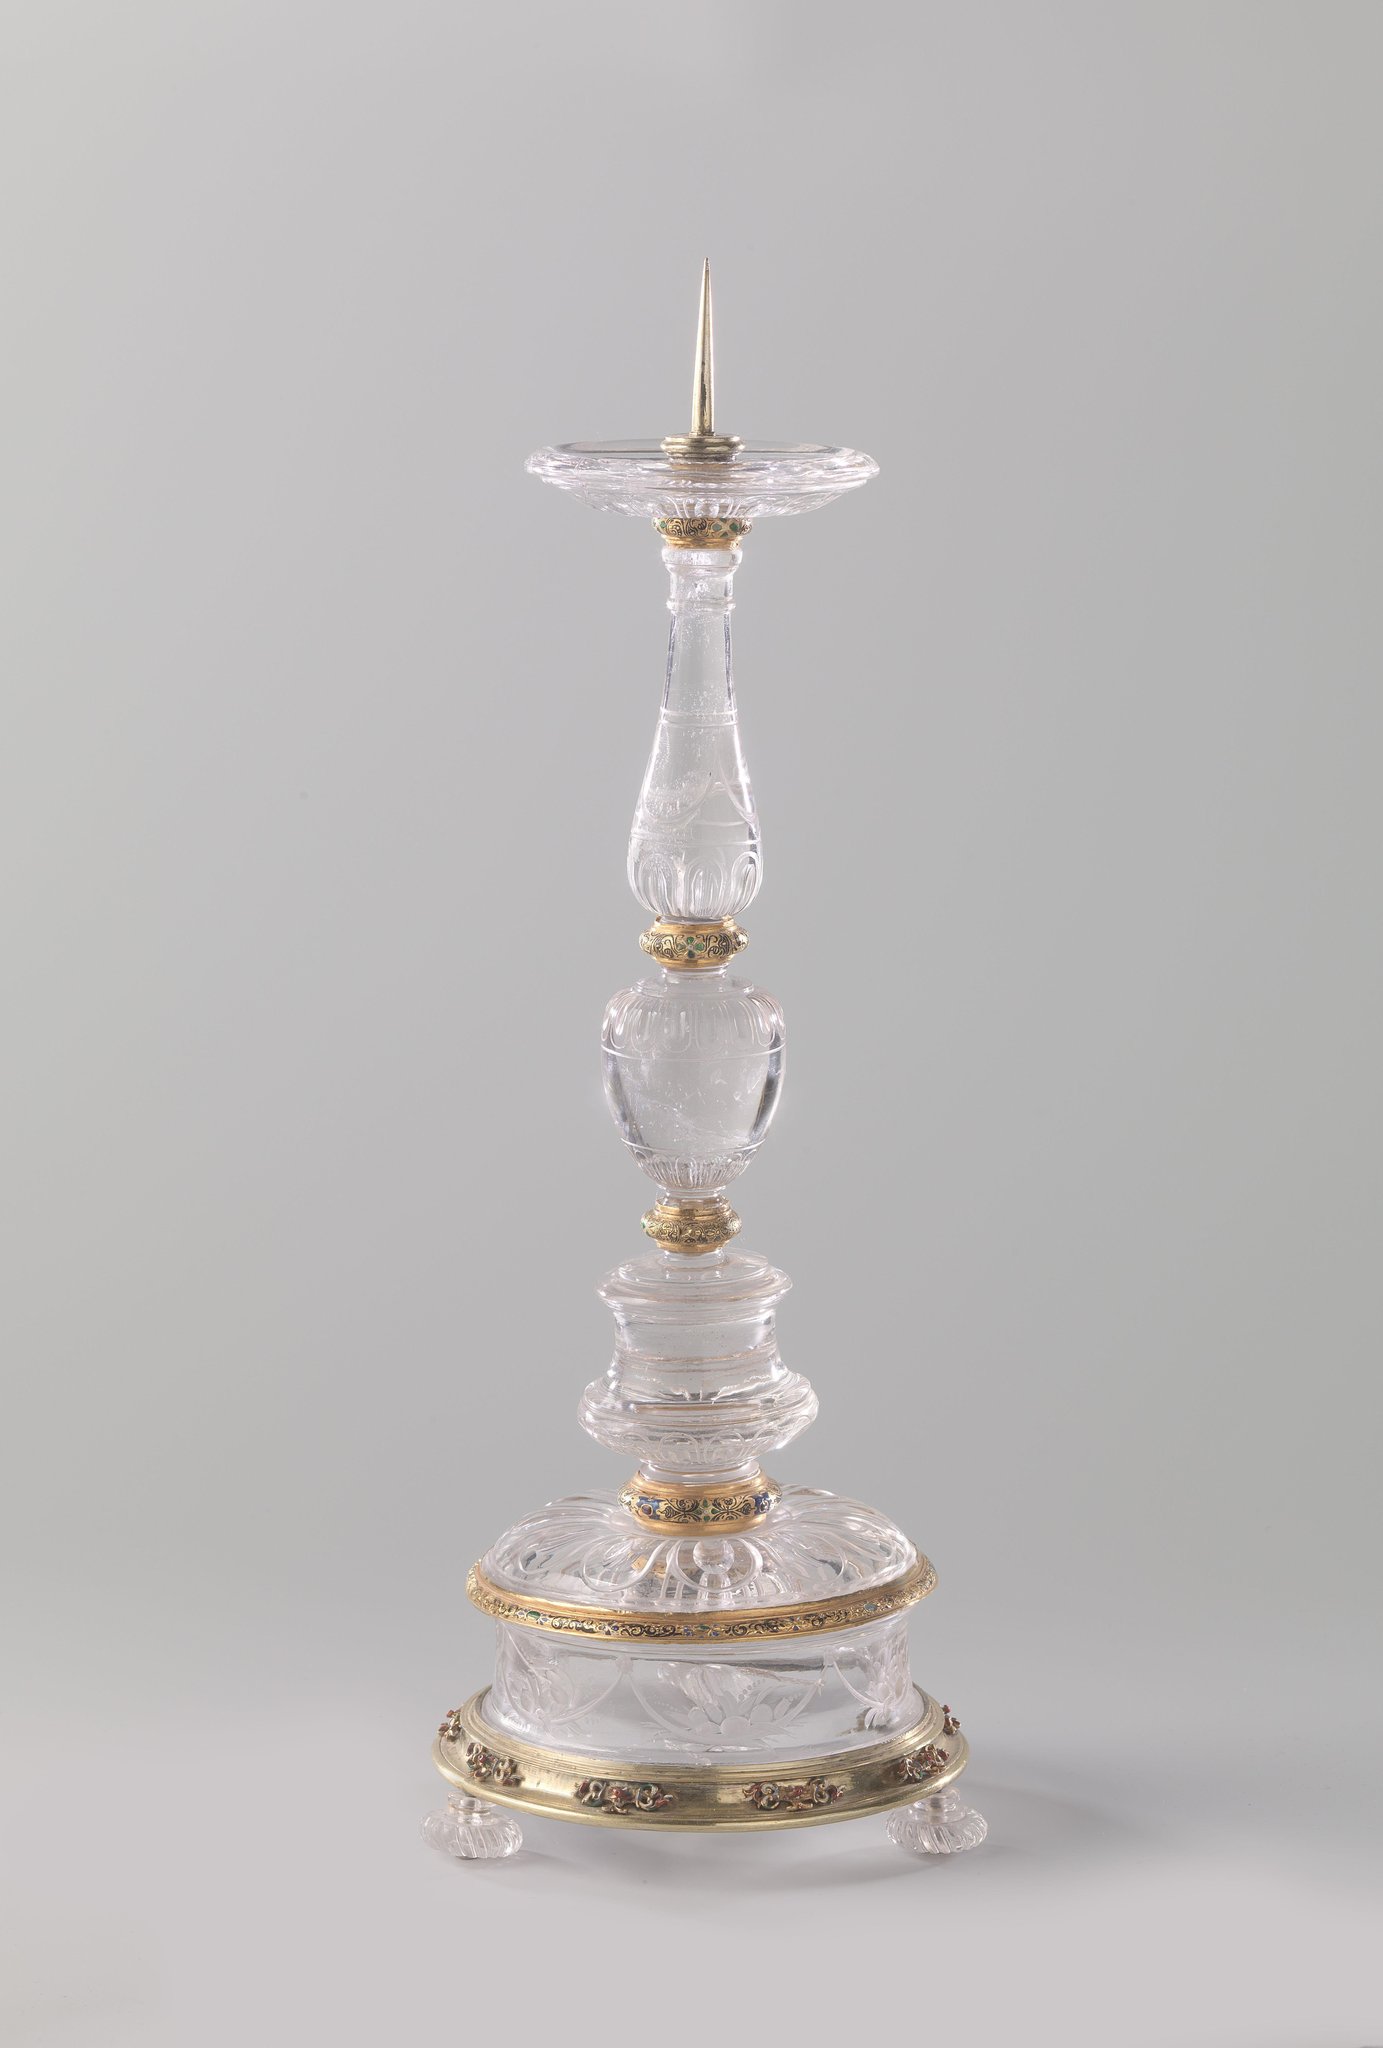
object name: candlestick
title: Kandelaar met kaarsenpin en vetvanger van bergkristal in montuur van goud en verguld zilver met email. Voet versierd met guirlandes en vruchtentrossen in slijpwerk.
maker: Anonymous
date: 1550-1600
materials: gold, silver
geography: italy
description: Two candlesticks. Rock crystal, gold, silver-gilt and enamel. Italy(?), c. 1550-1600, the lower rim 19th century.